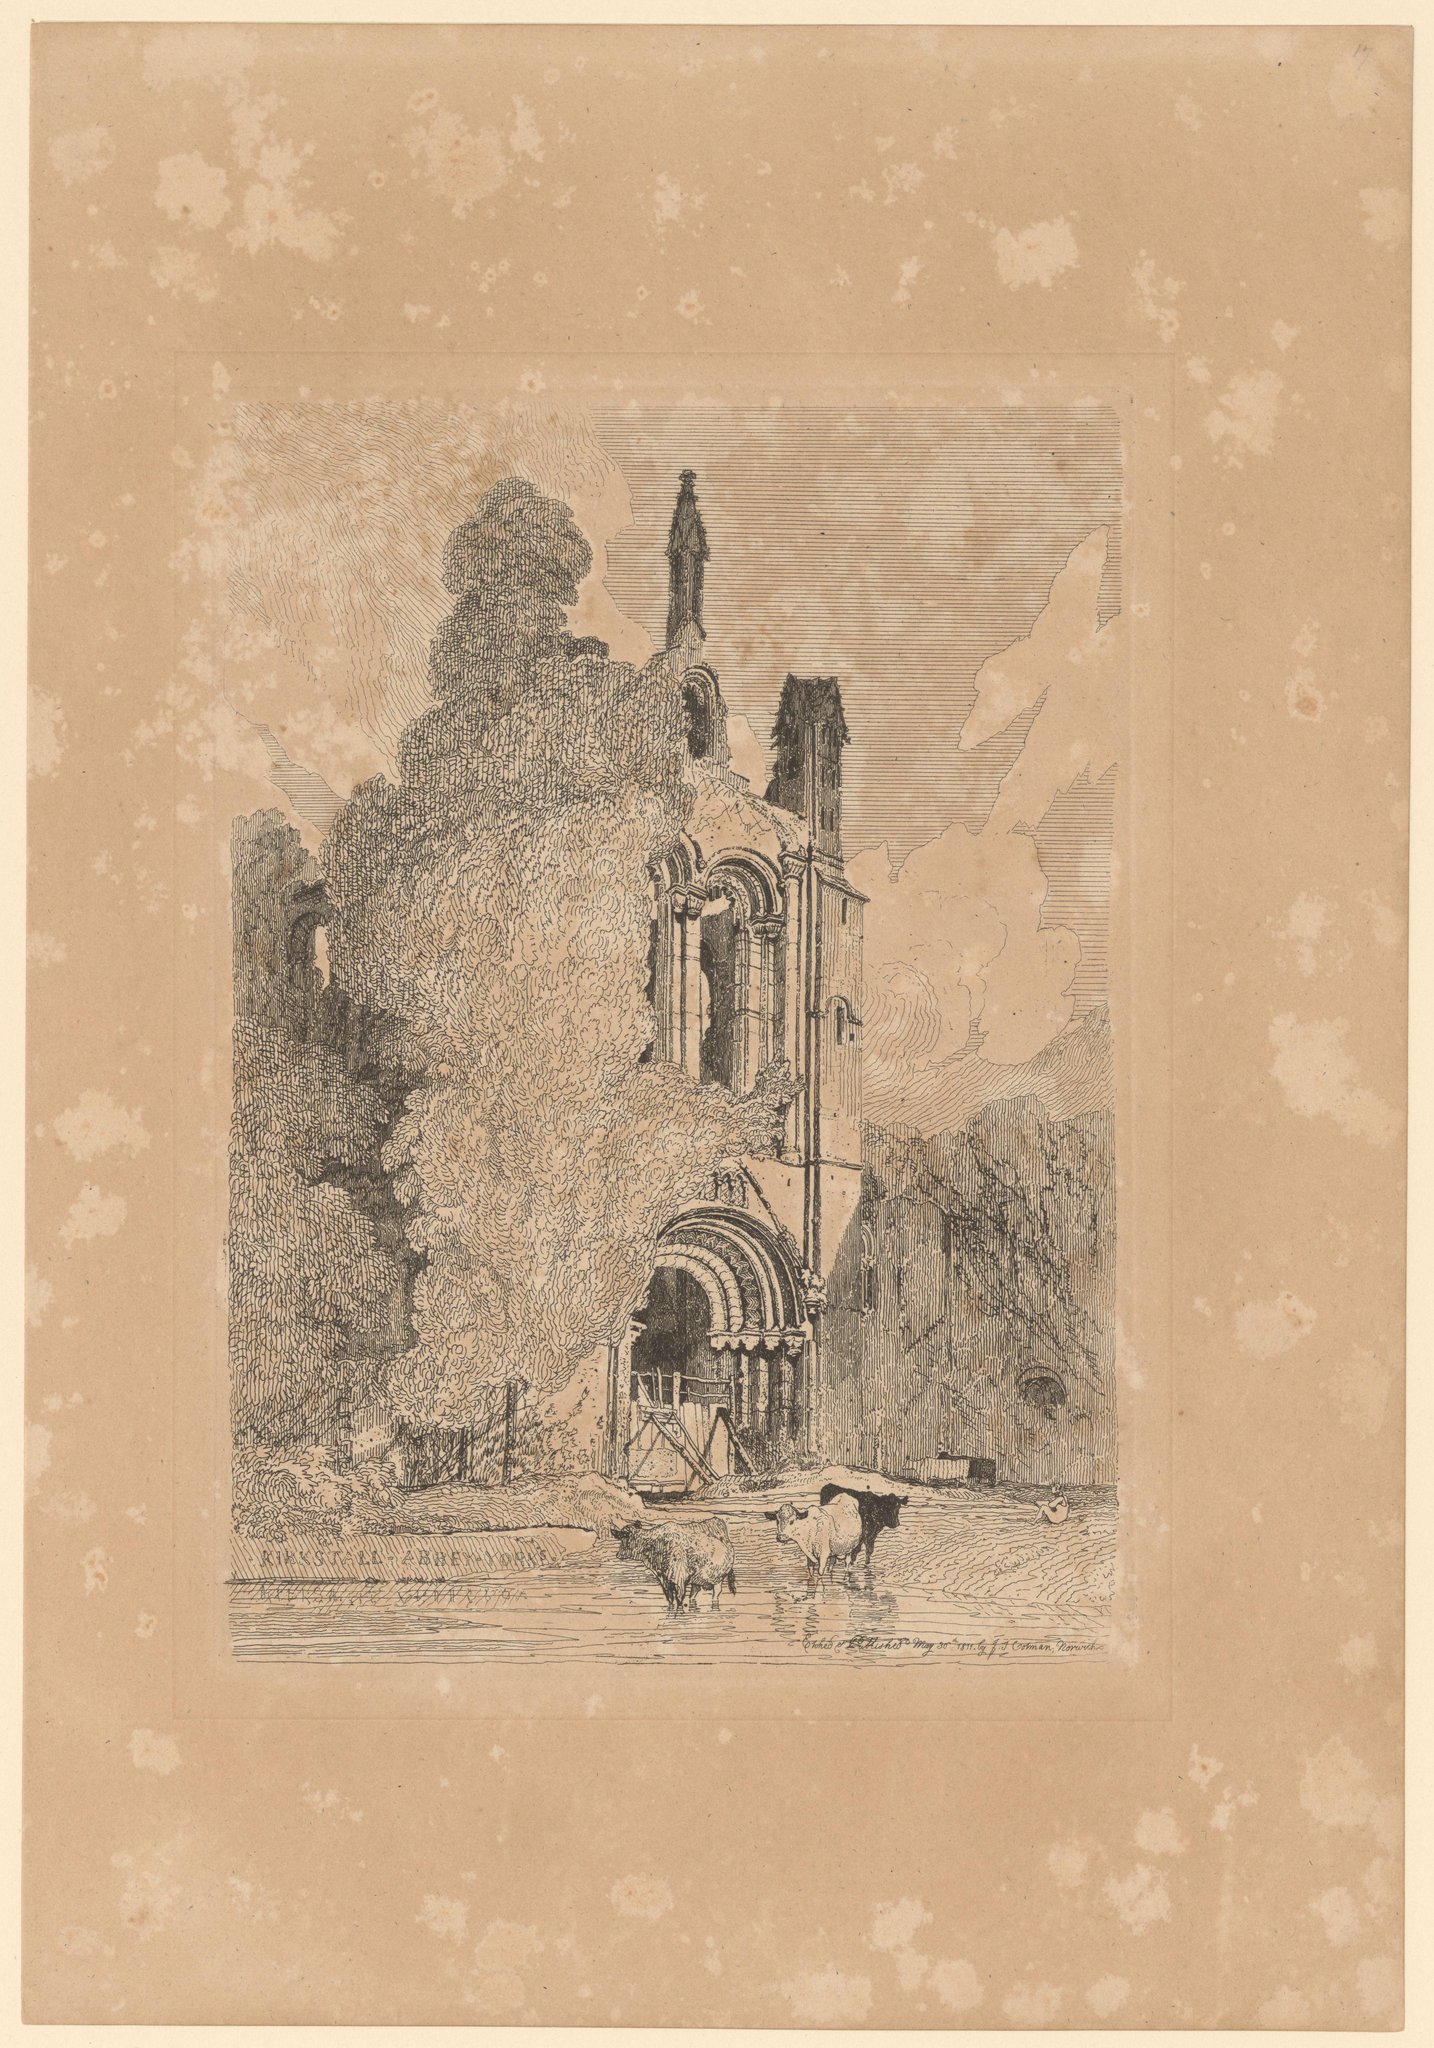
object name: print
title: Kirkstall Abbey, Yorks[hire]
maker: john sell cotman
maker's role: draughtsman, print maker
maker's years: 1782-1842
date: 1805-1811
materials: paper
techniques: etching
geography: norwich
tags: cow, ruin of church, monastery, etc., brook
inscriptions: collector's mark: Lugt 2760, collector's mark: Lugt 2228